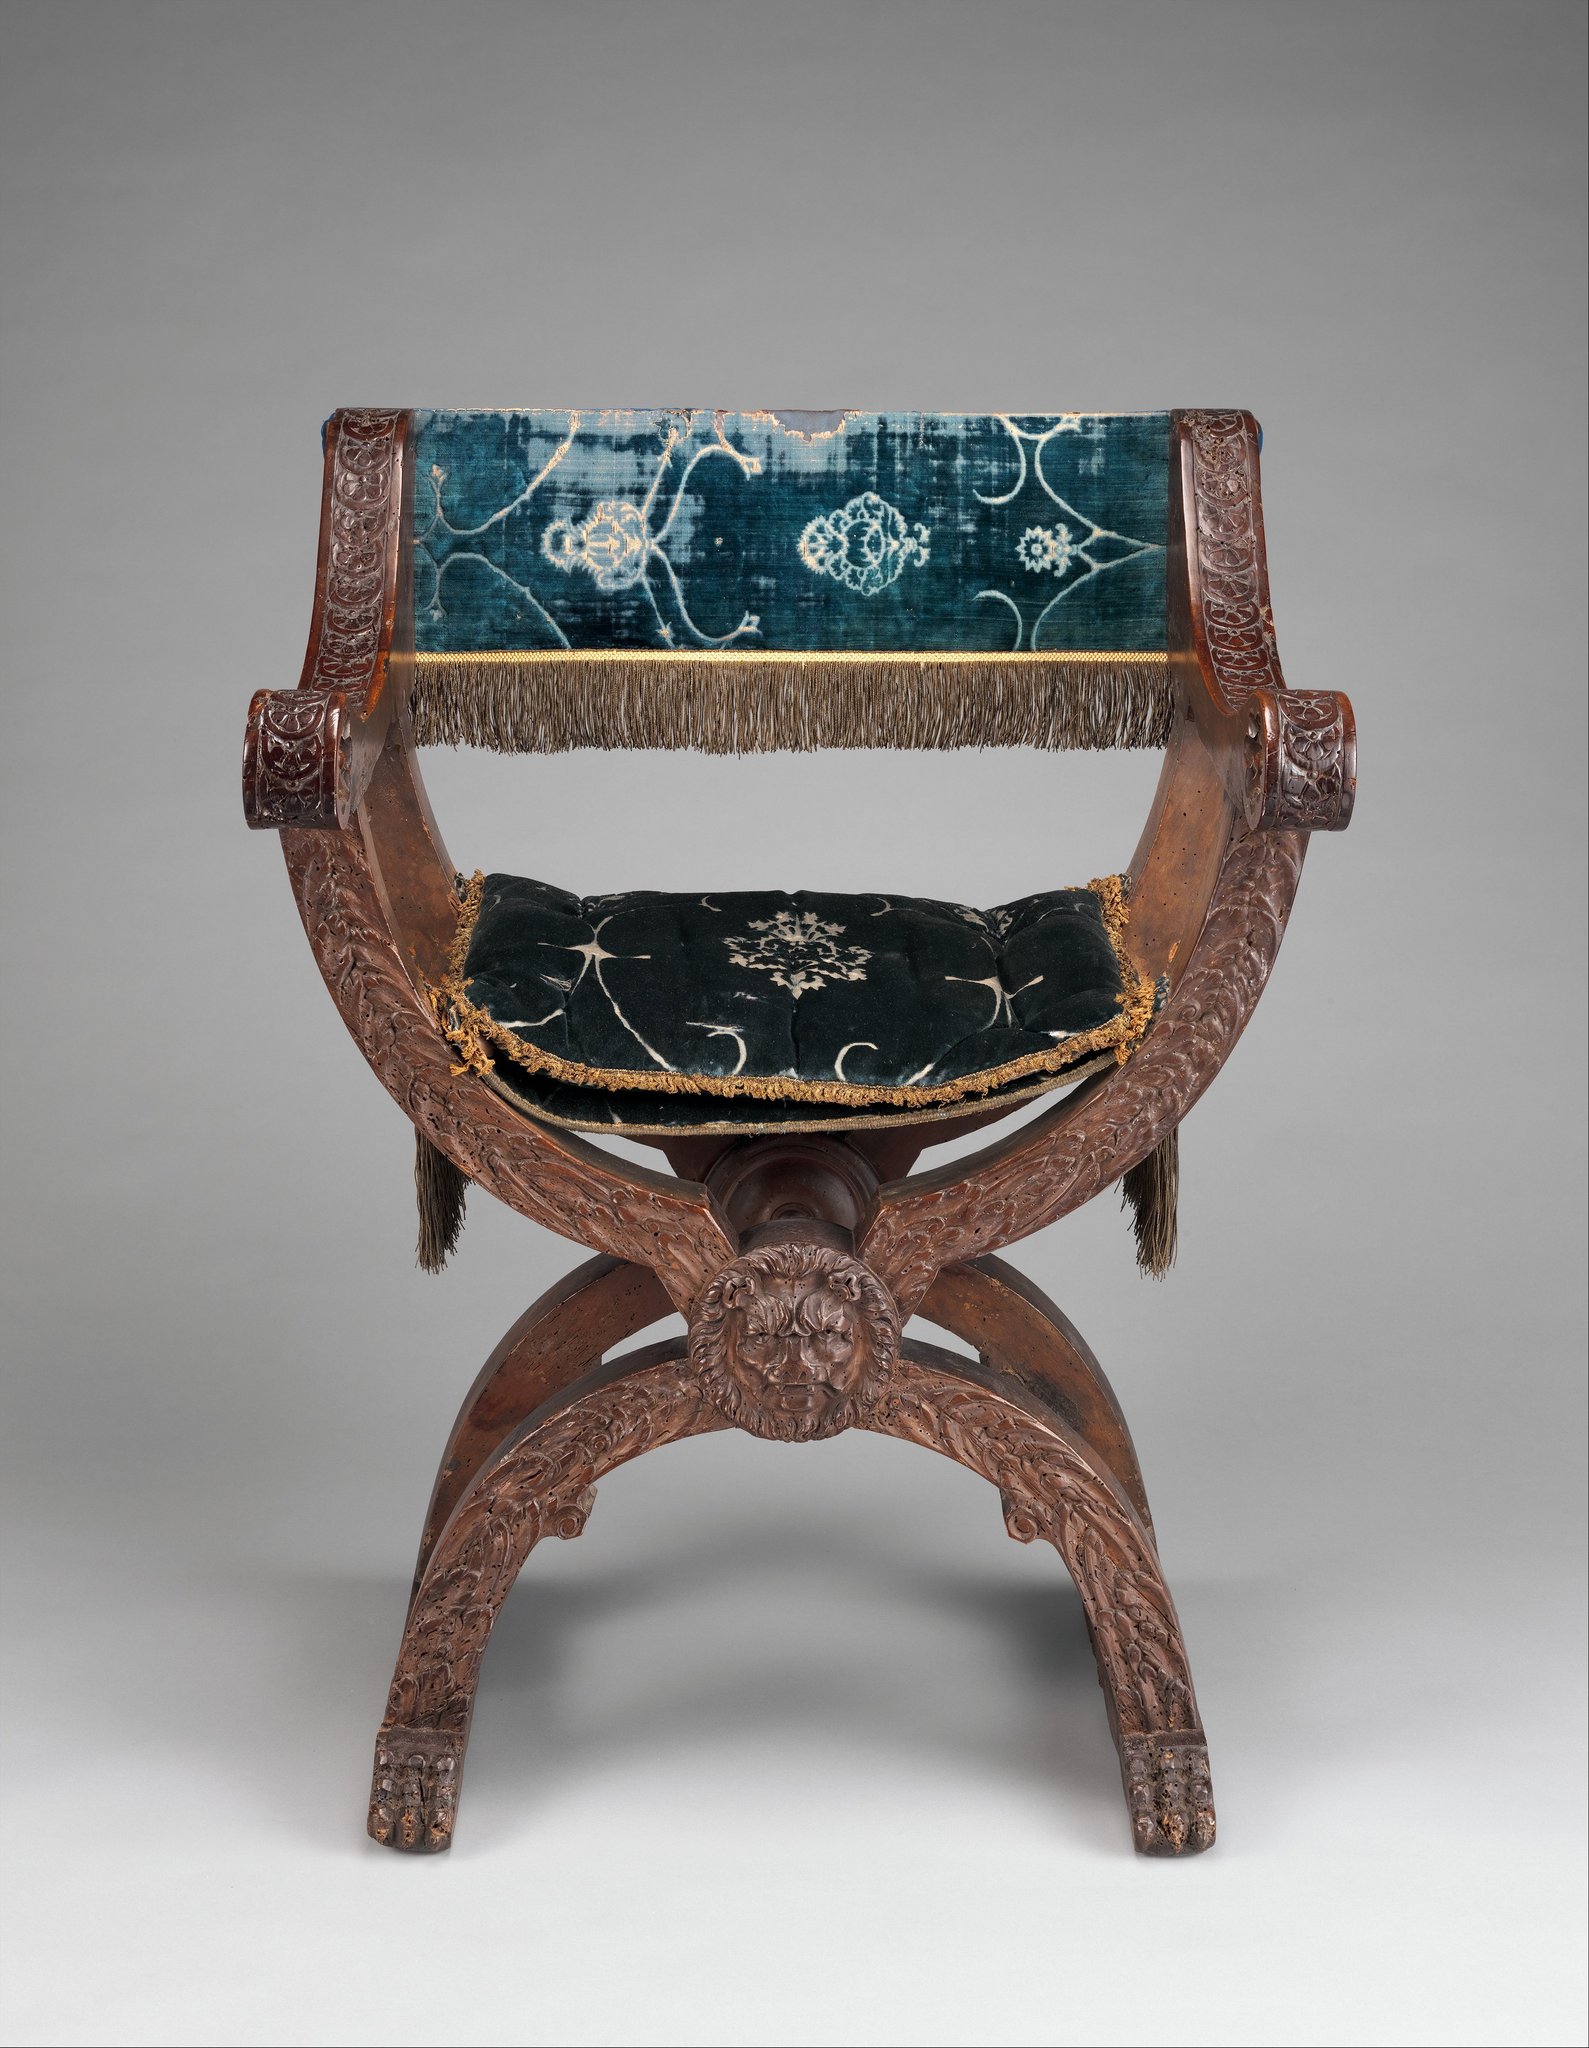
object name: armchair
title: Hip-joint armchair (Dantesca type, associated with 1975.1.1976 a,b)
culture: italian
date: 1501-1600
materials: metal, silk, velvet, wood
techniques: carving, cutting